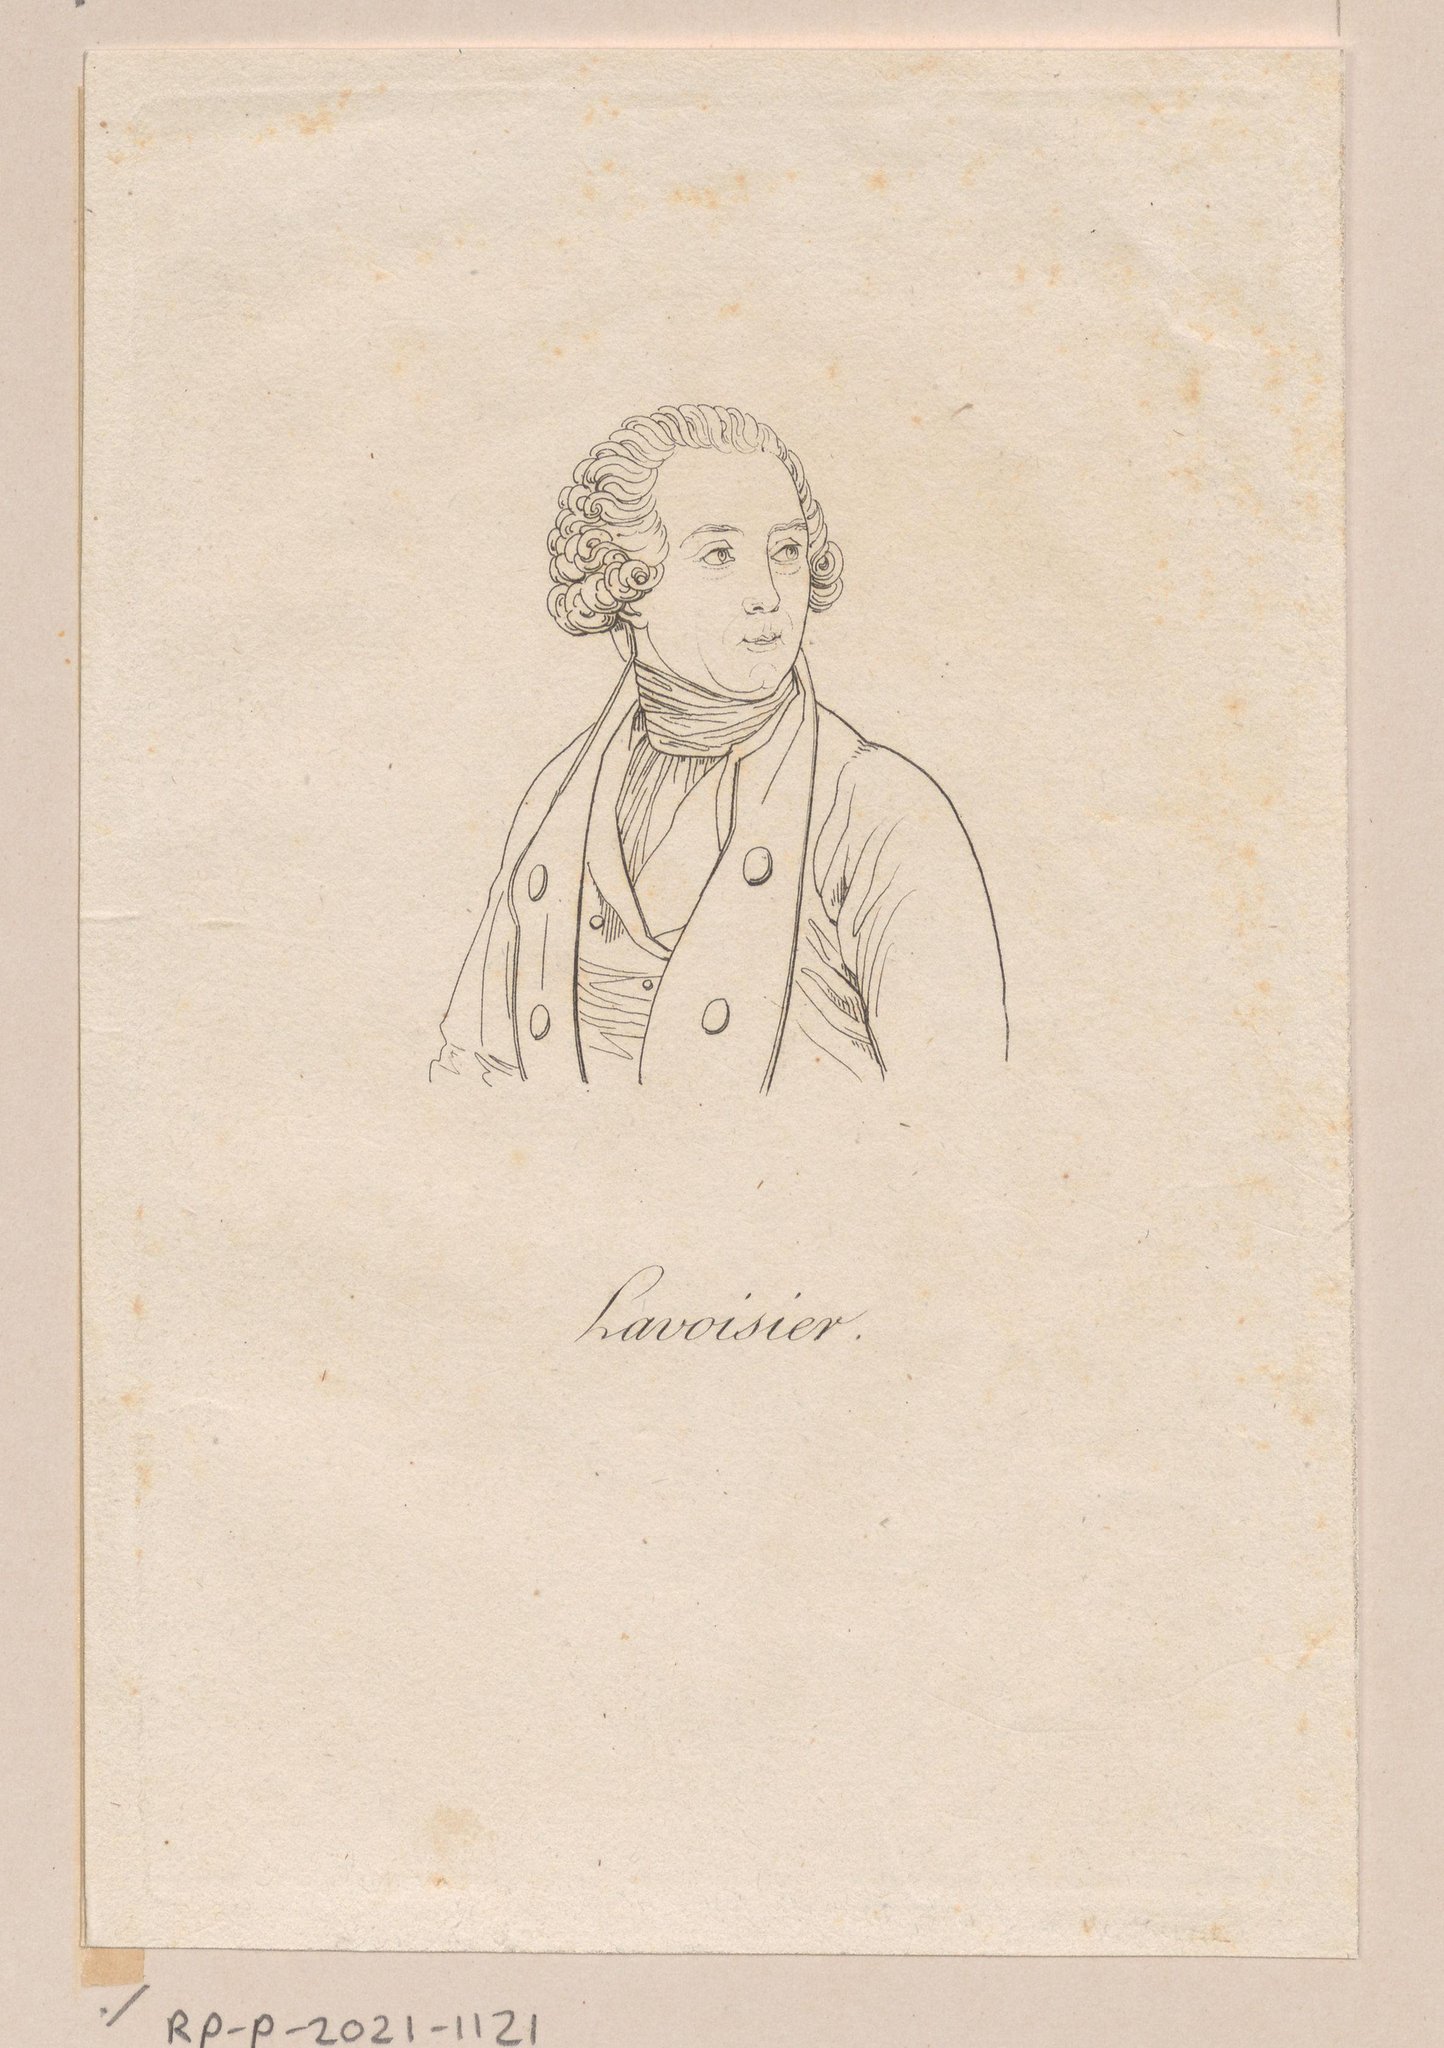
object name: print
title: Portret van Antoine Lavoisier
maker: Anonymous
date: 1800-1899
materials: paper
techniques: etching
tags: paris, chemistry (+ portrait of scholar, scientist), historical persons